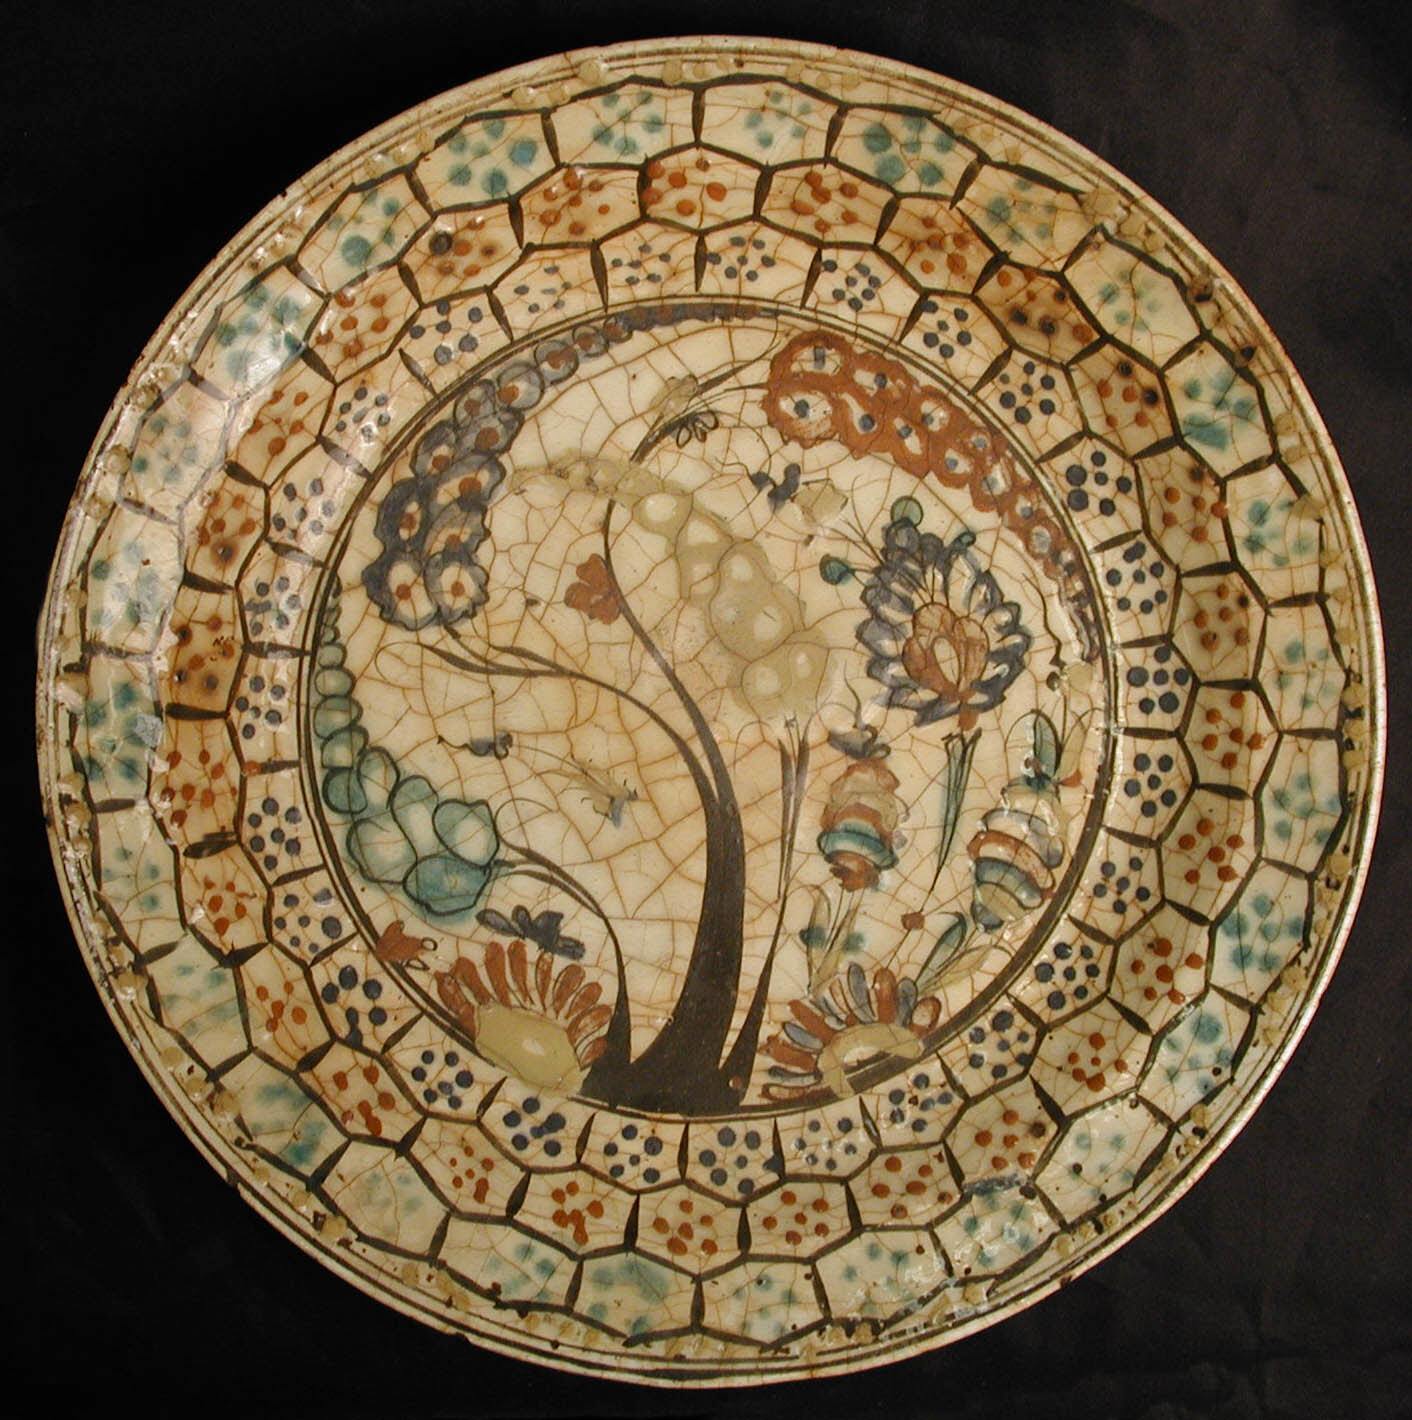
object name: dish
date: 1601-1700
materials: stonepaste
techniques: painting, underglaze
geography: iran